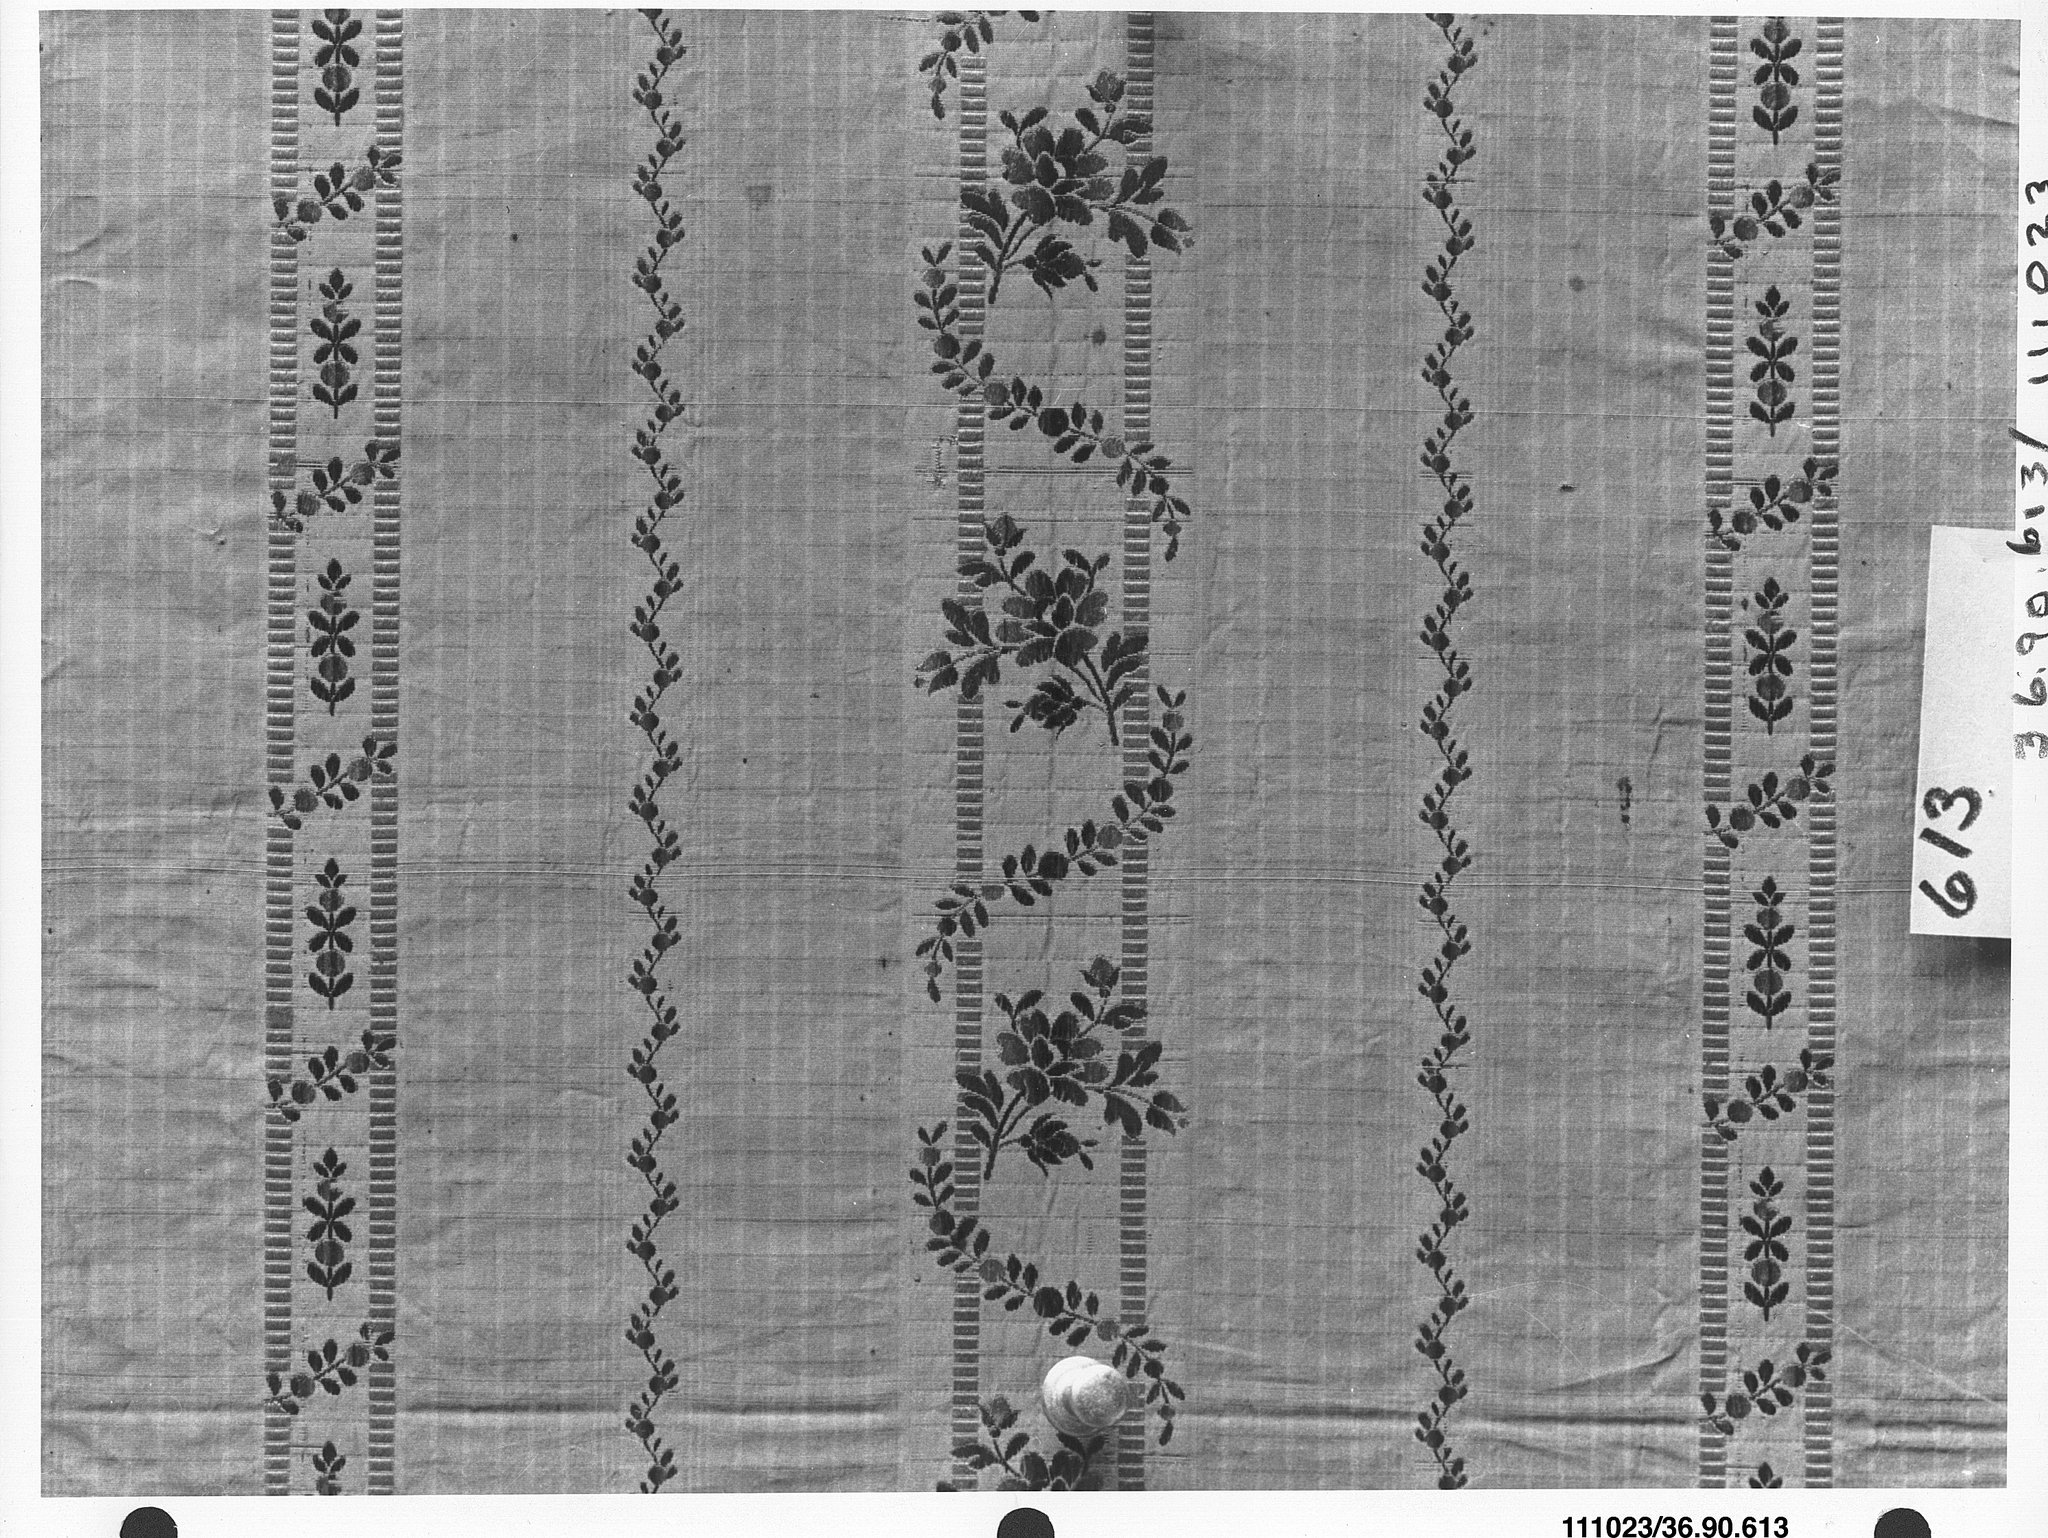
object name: piece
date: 1767-1800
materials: silk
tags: flowers